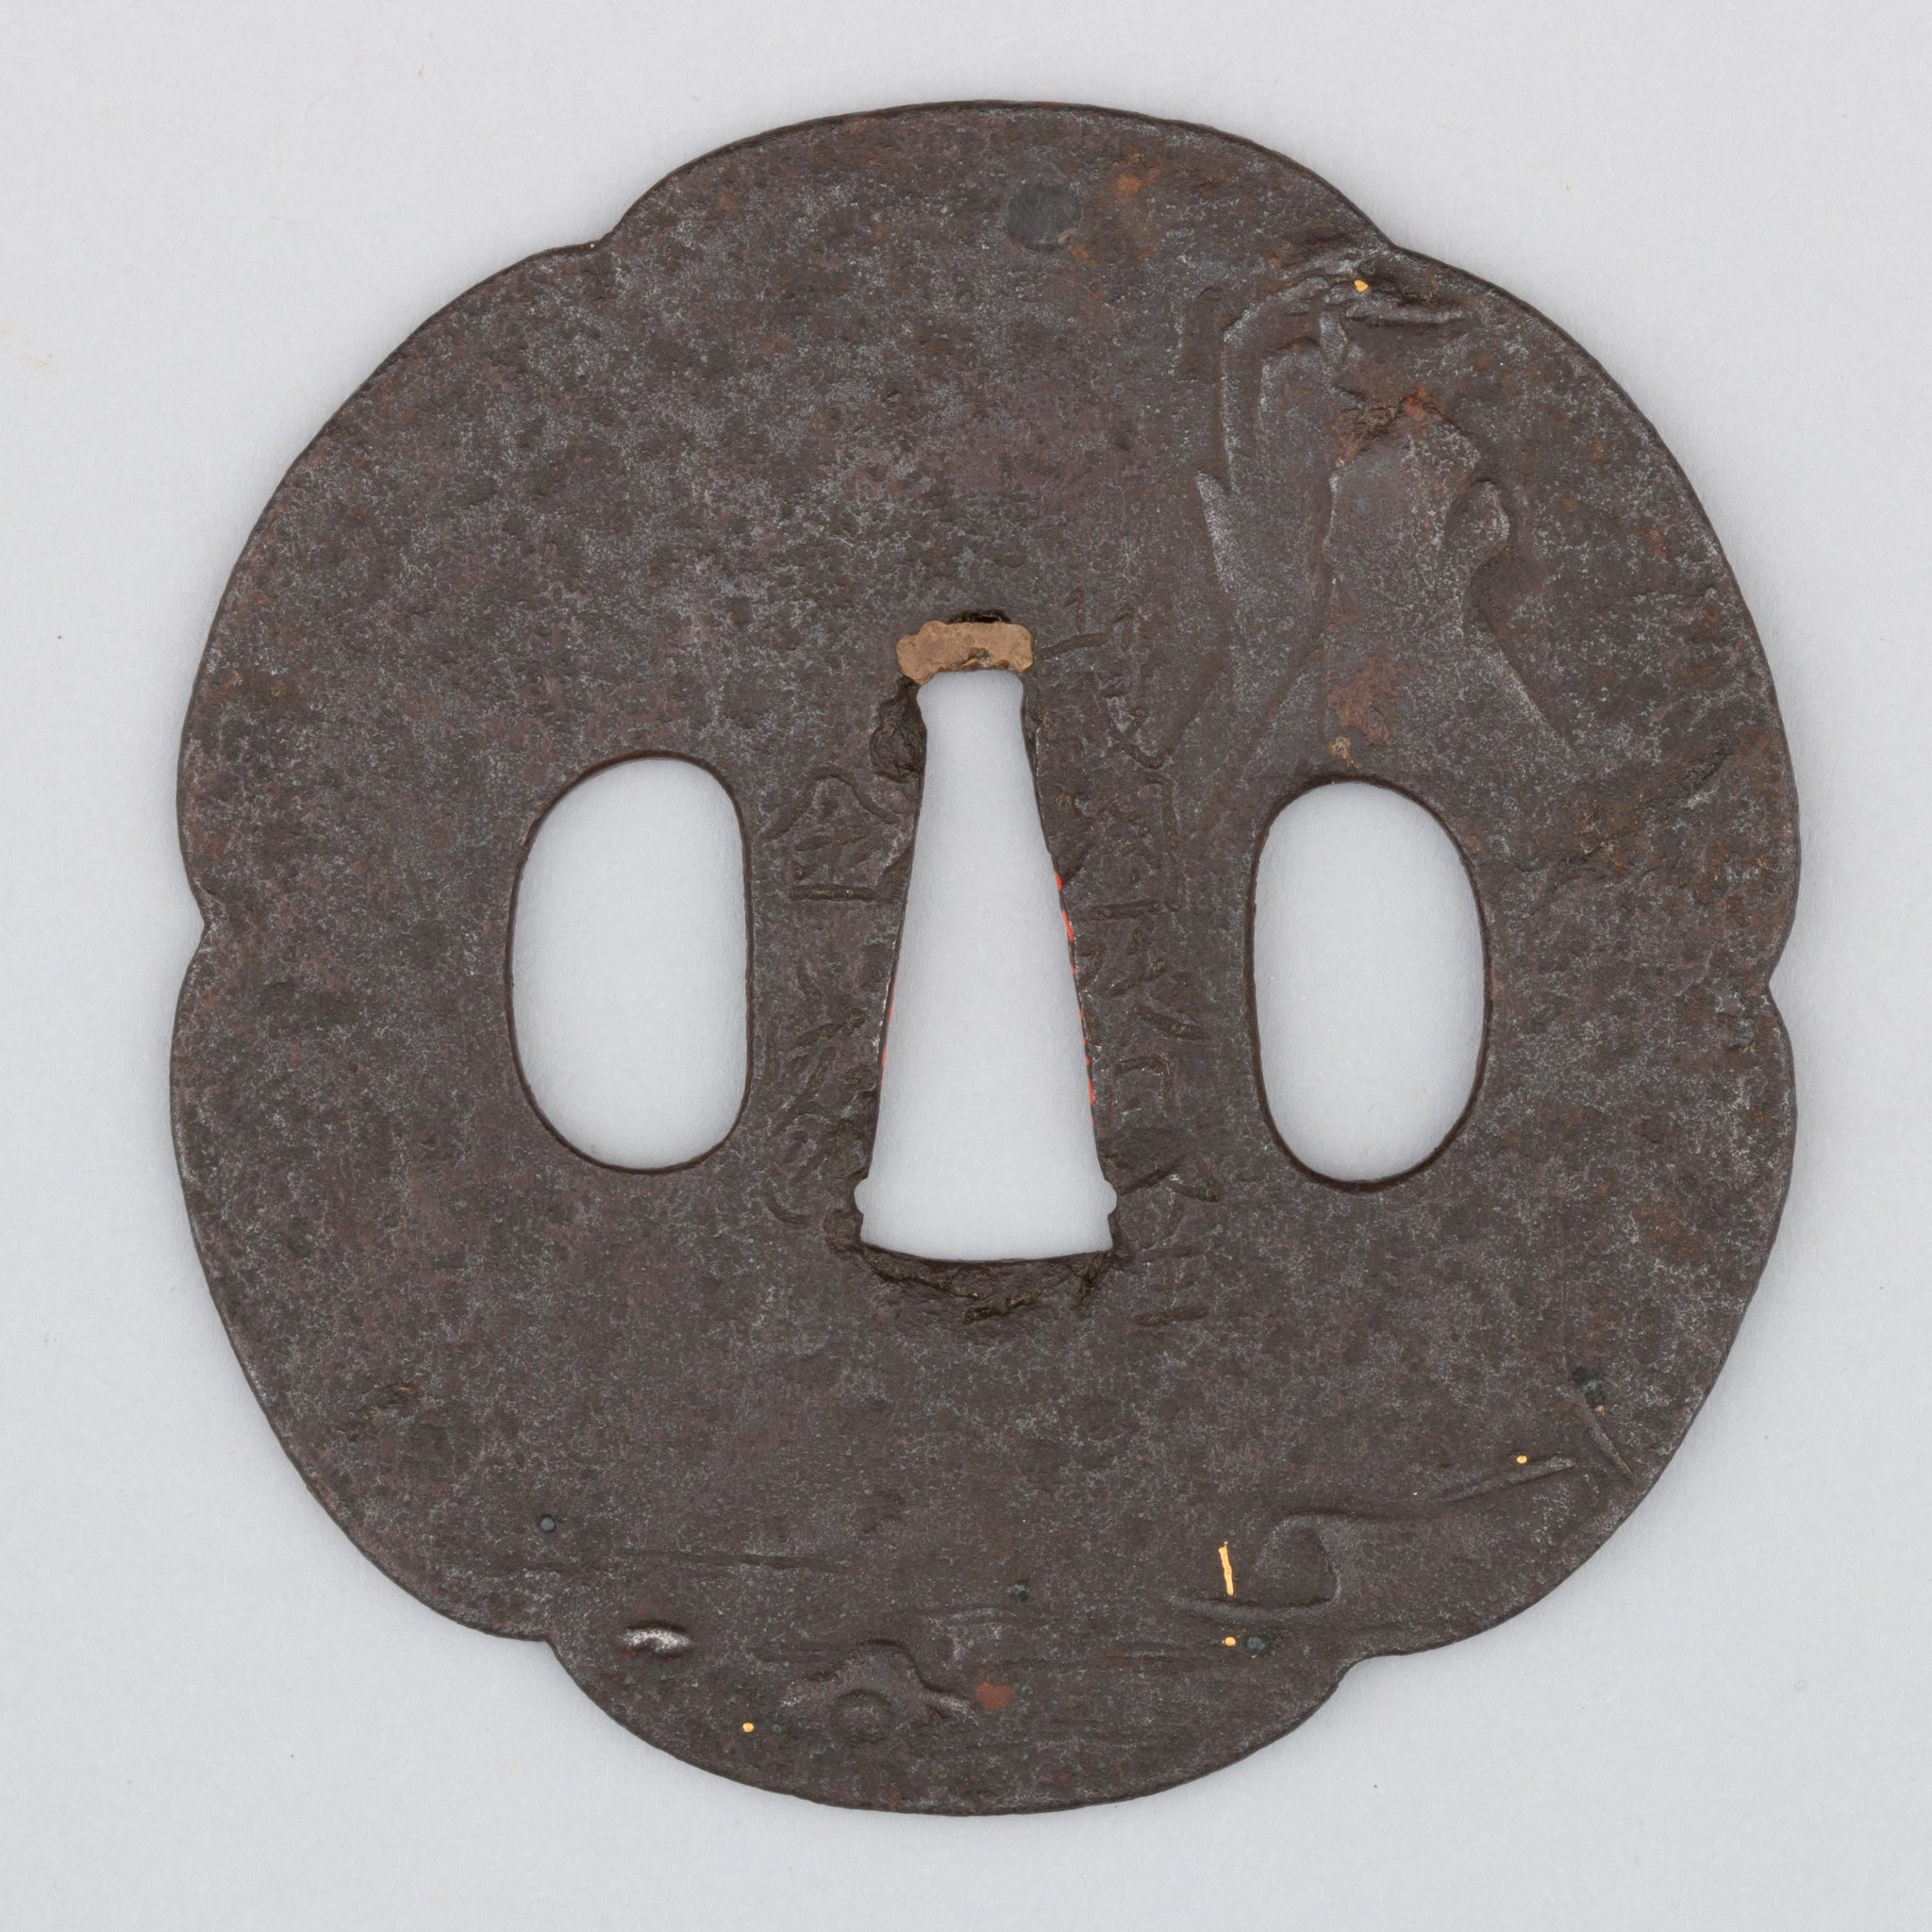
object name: sword guard tsuba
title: Sword Guard (Tsuba)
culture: japanese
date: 1615-1868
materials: copper, iron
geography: japan